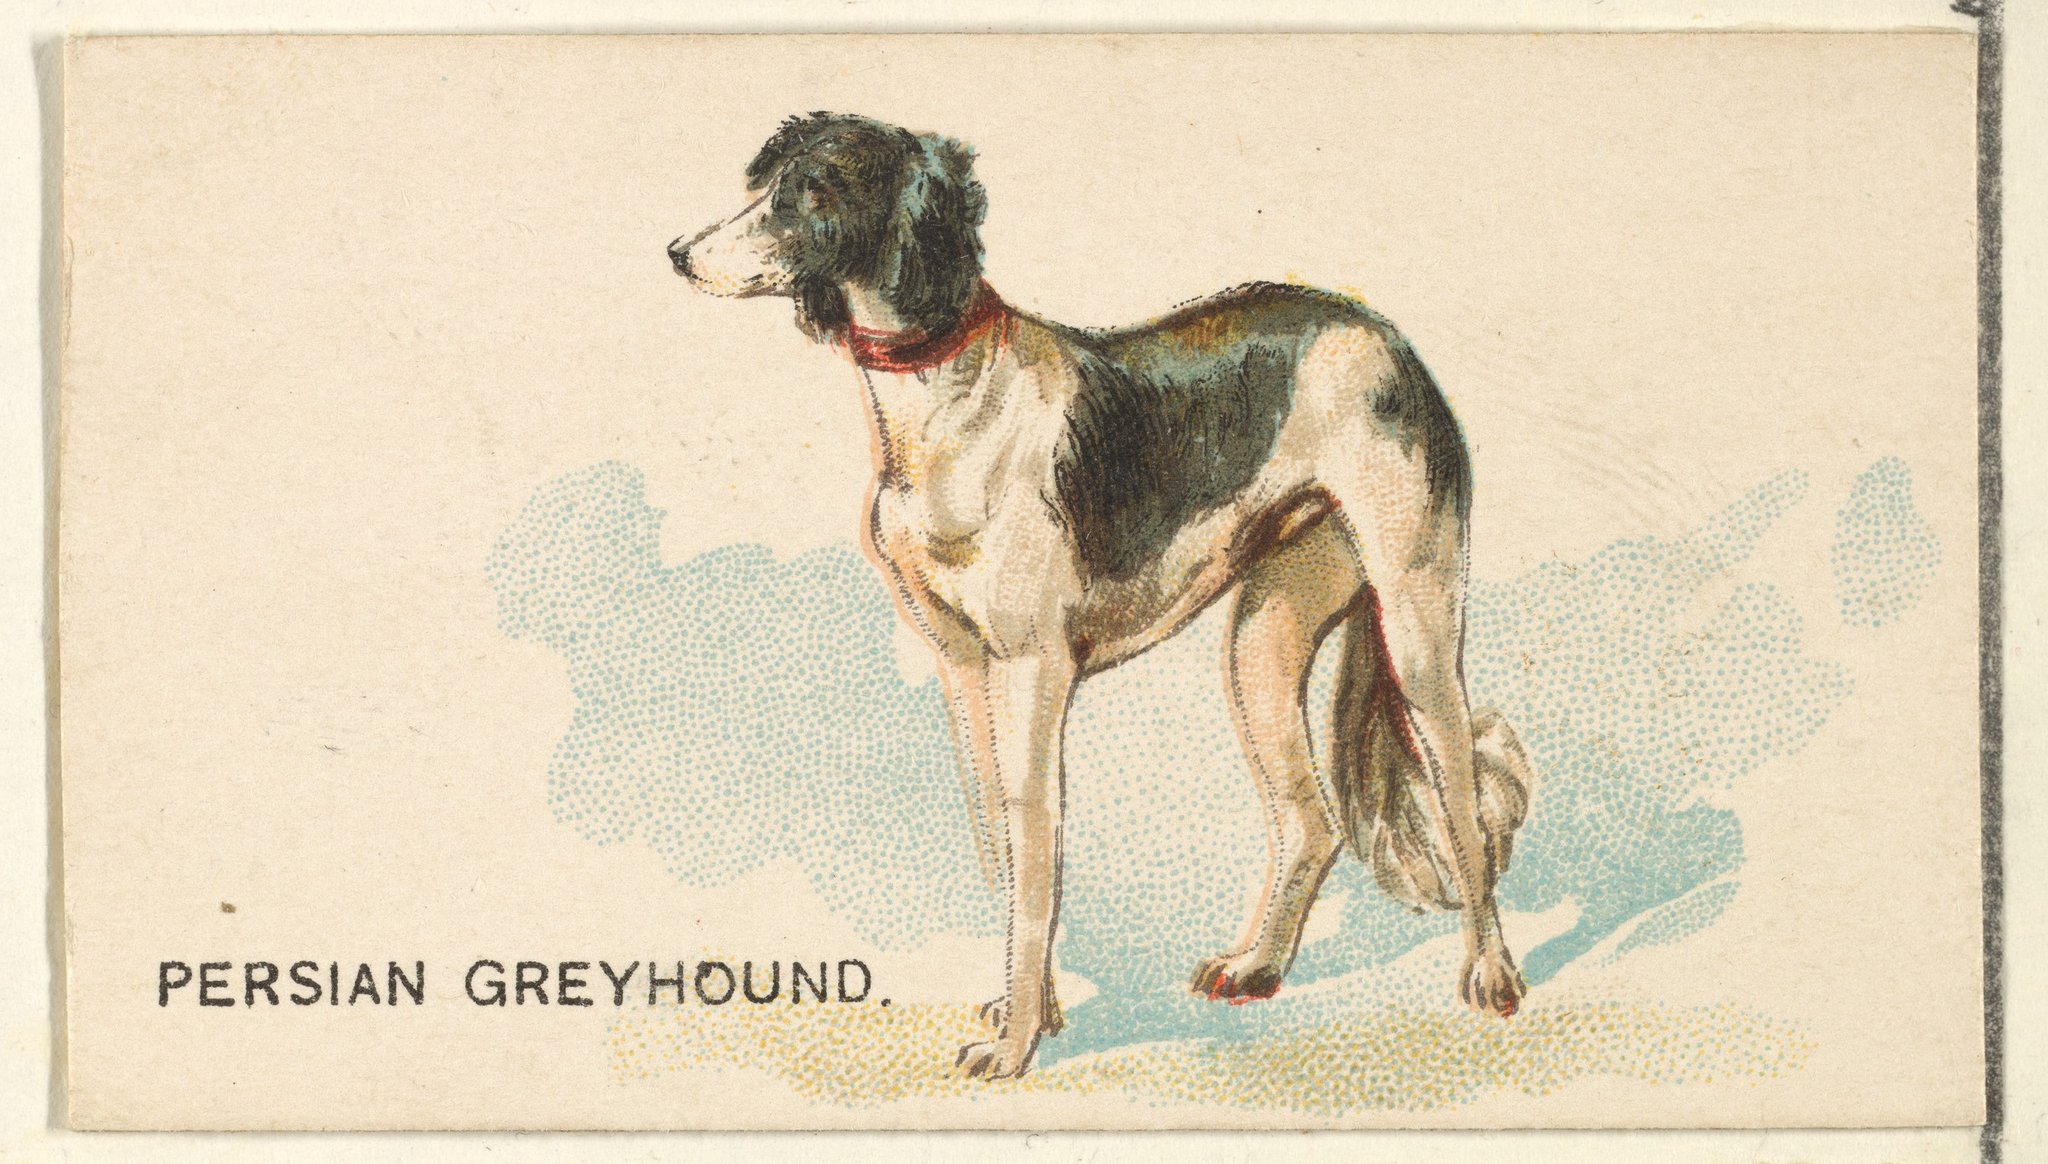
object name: print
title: Persian Greyhound, from the Dogs of the World series for Old Judge Cigarettes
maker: goodwin & company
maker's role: publisher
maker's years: 1850-1950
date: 1890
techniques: color lithograph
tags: dogs